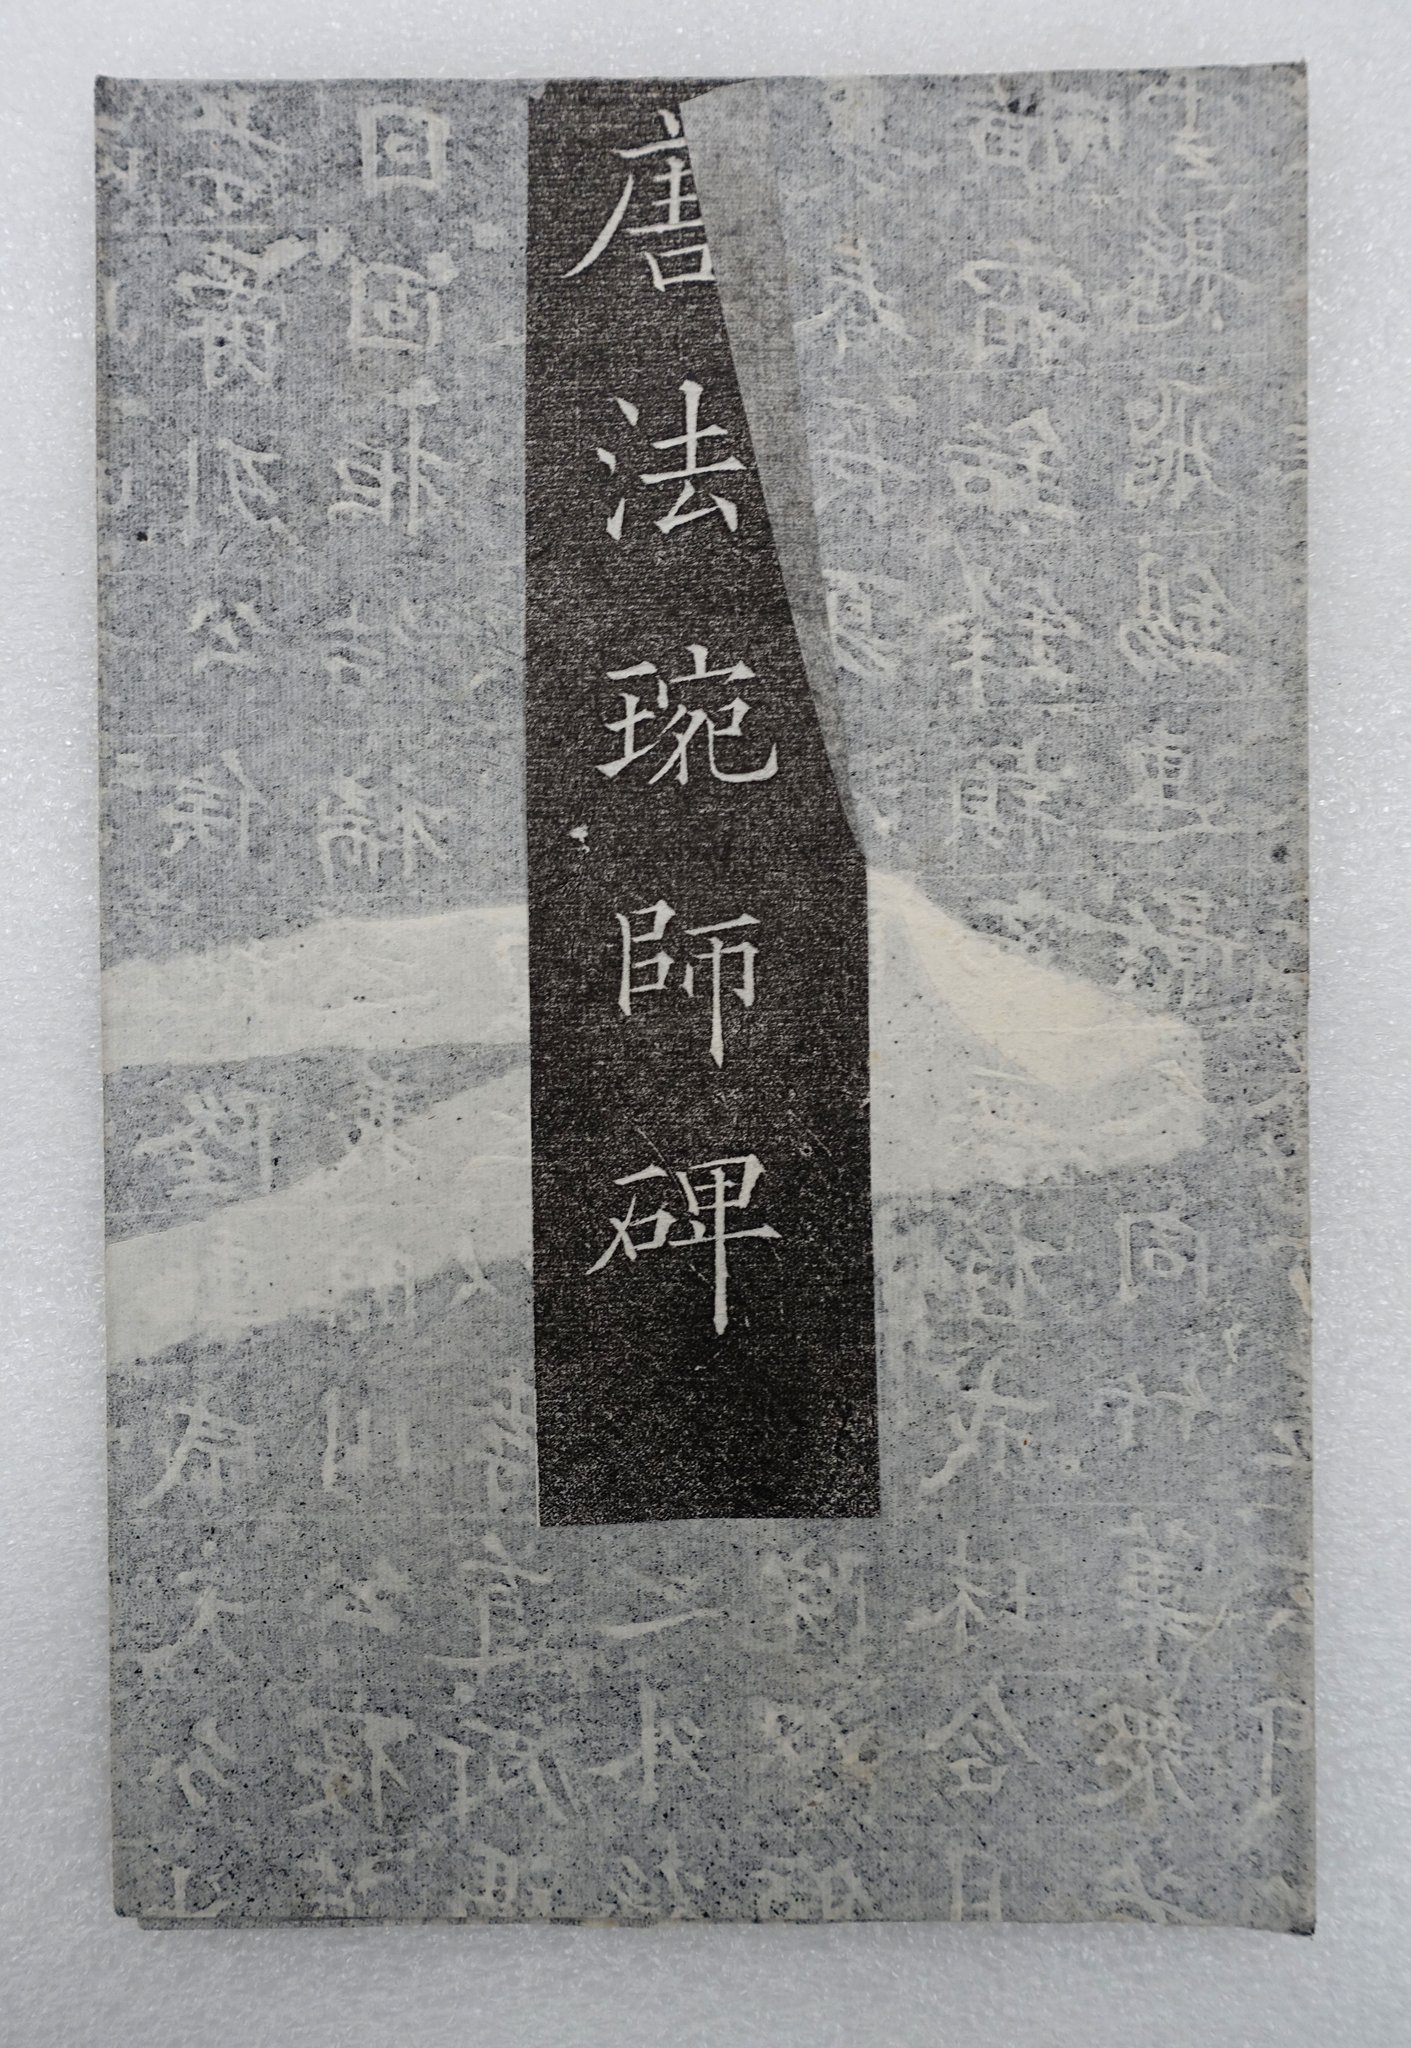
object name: rubbing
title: Epitaph for Zhe Chan Master Fawan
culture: chinese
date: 1901-2000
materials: ink, paper